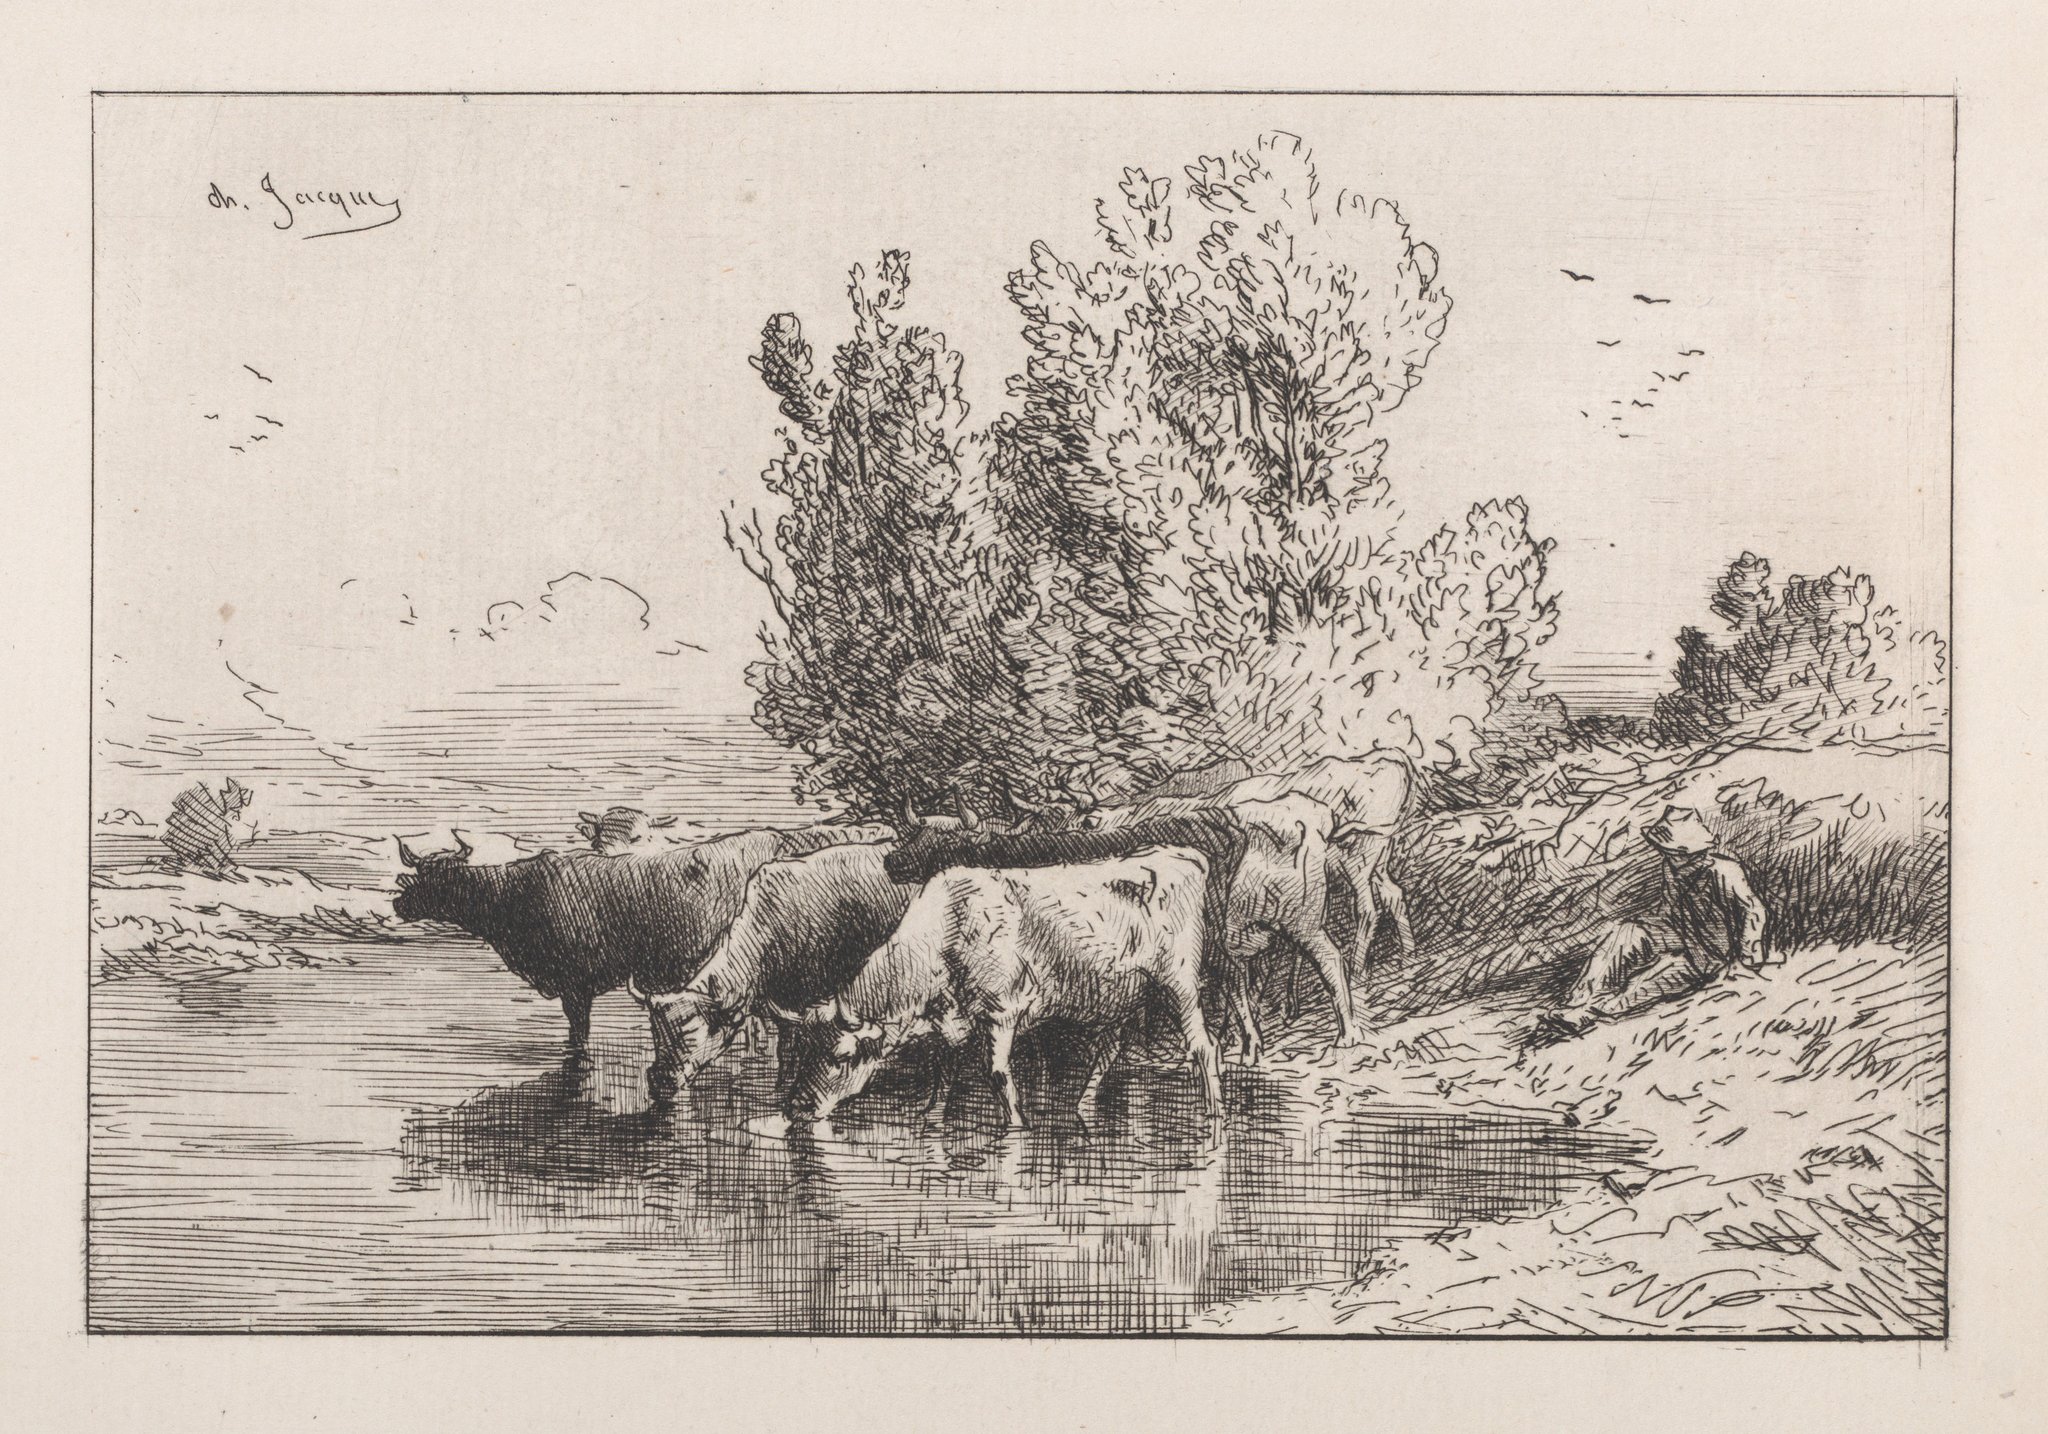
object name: print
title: The Trough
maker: charles émile jacque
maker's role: artist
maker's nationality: french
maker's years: 1813-1894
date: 1864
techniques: etching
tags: cows